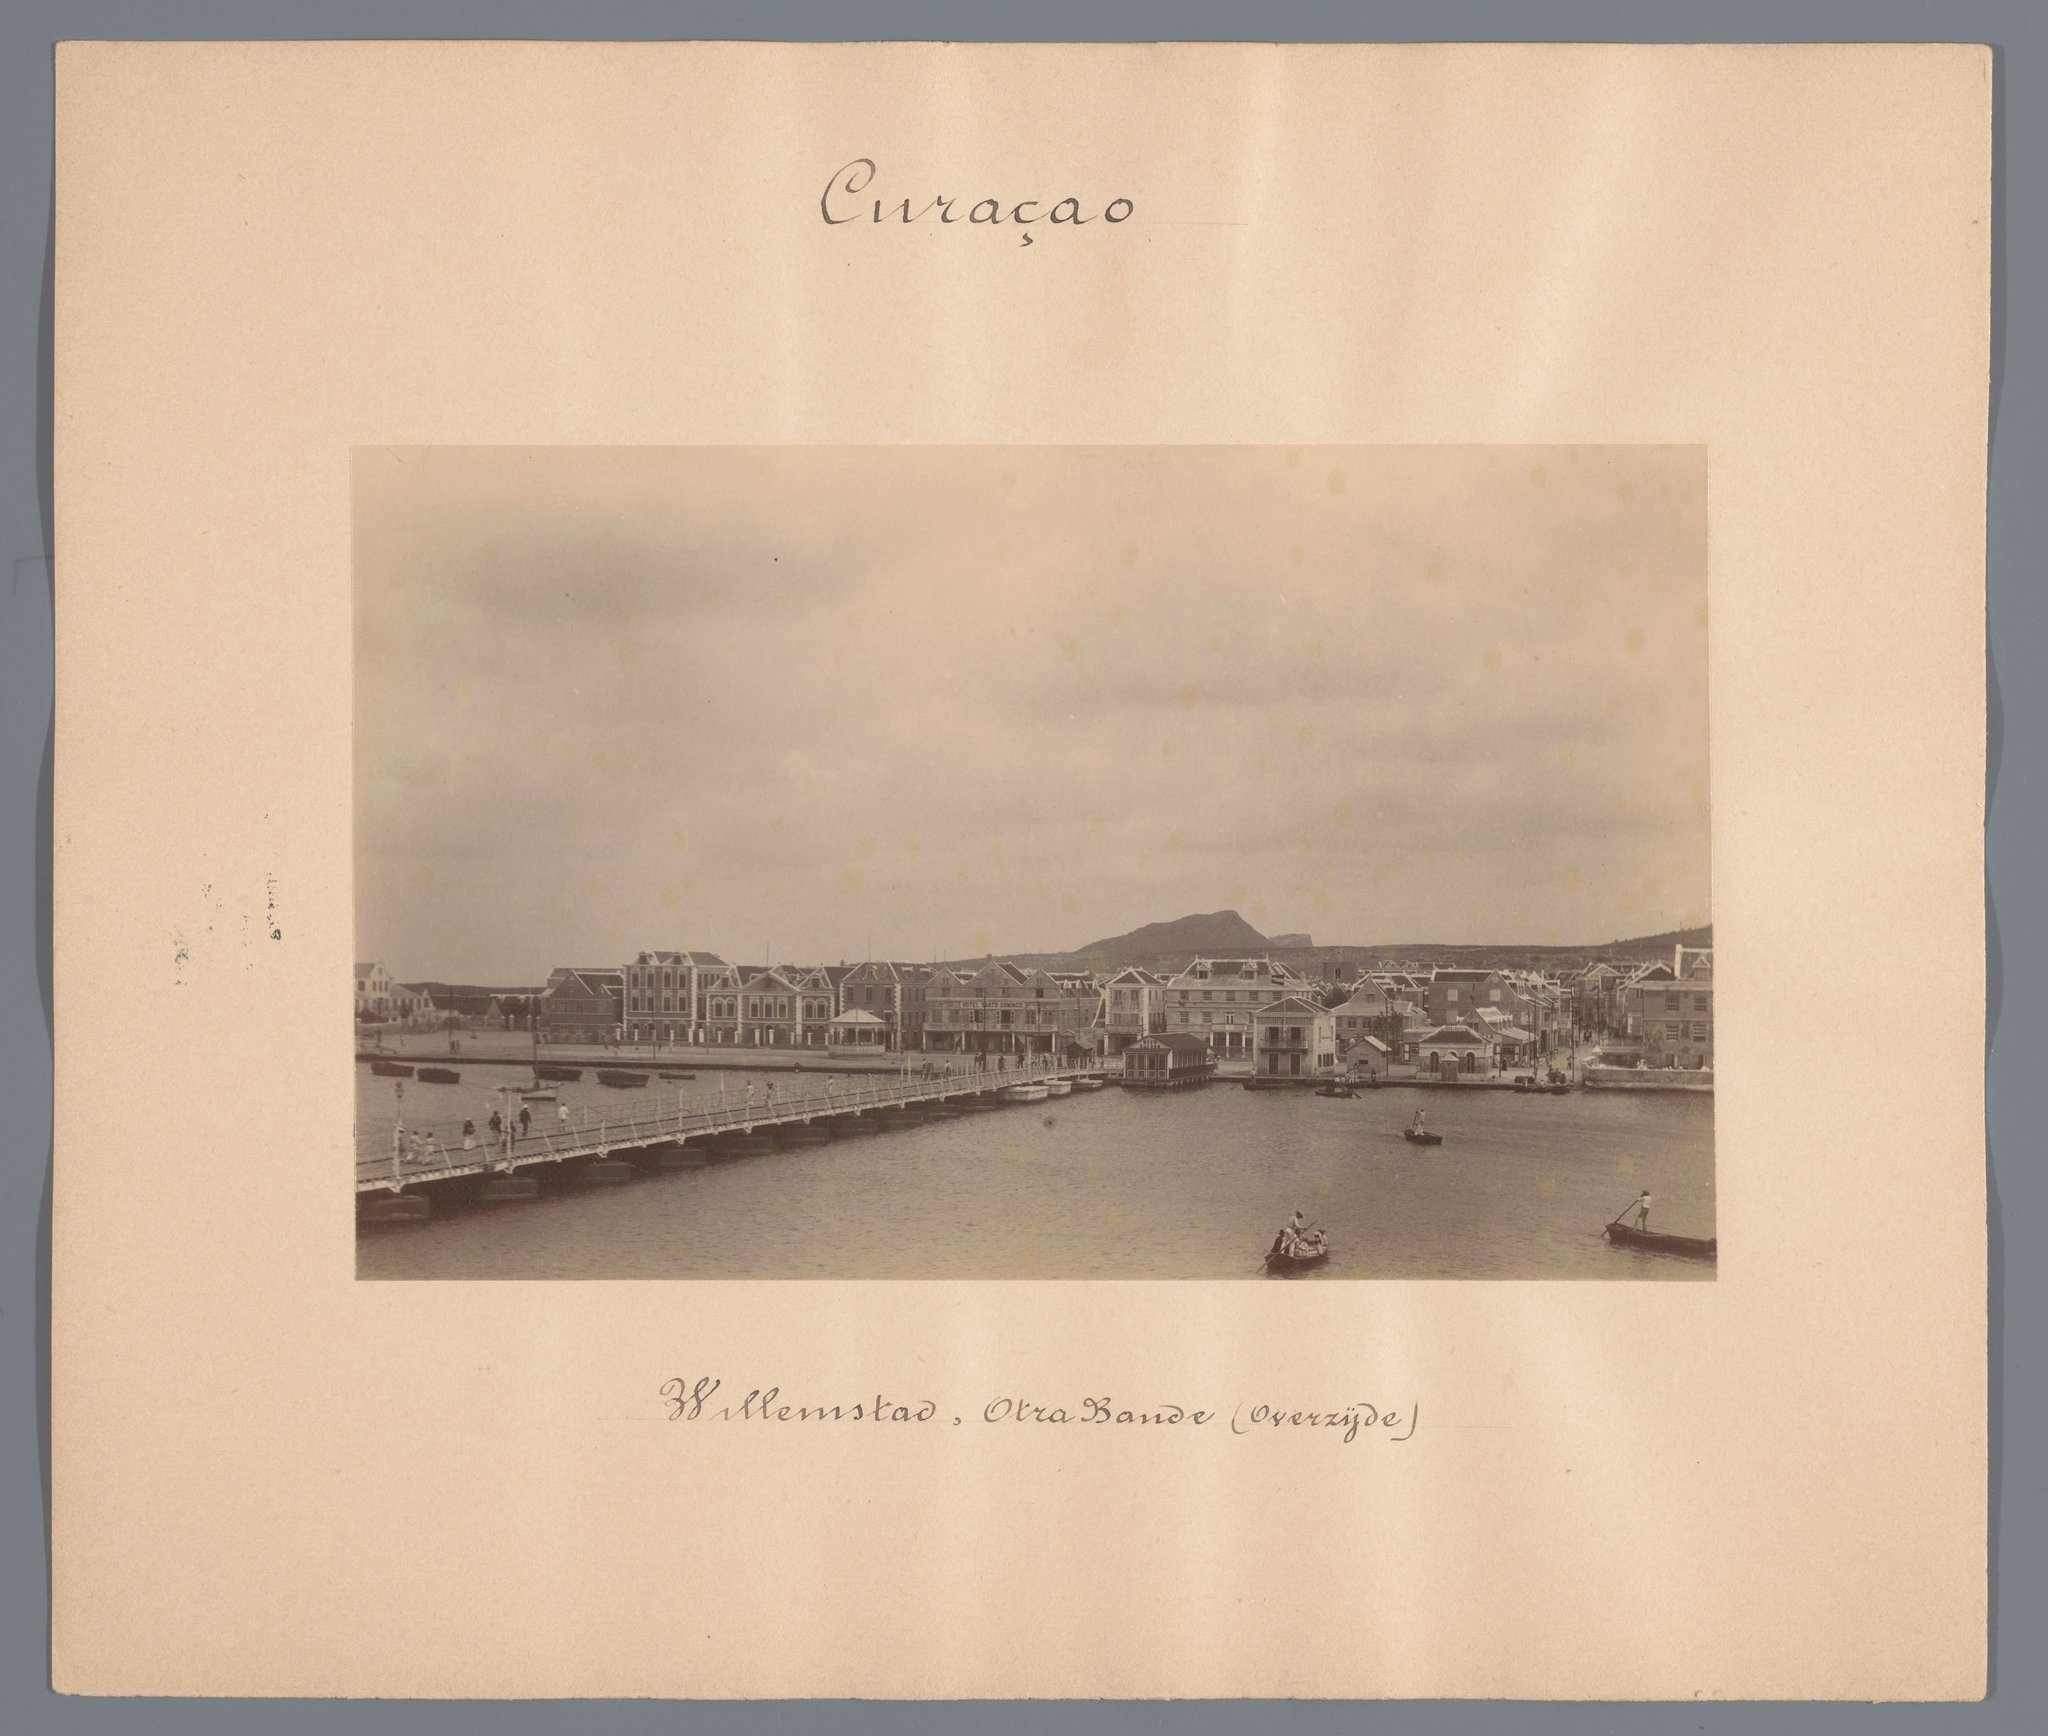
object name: photograph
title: Willemstad, Otra Bande (overzijde)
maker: Anonymous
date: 1900-1905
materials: cardboard, photographic support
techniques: gelatin silver print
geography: willemstad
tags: willemstad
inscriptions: inscription: ‘Curaçao / Willemstad, Otra Bande (overzijde)’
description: Gezicht op de Otrobanda (De Overkant), een wijk in Willemstad op Curaçao. Op de voorgrond de Koningin Emmabrug. Onderdeel van een groep van 44 foto's van Paramaribo, Suriname en Curaçao, ca. 1900-1905, opgeplakt op kartons en voorzien van opschriften.